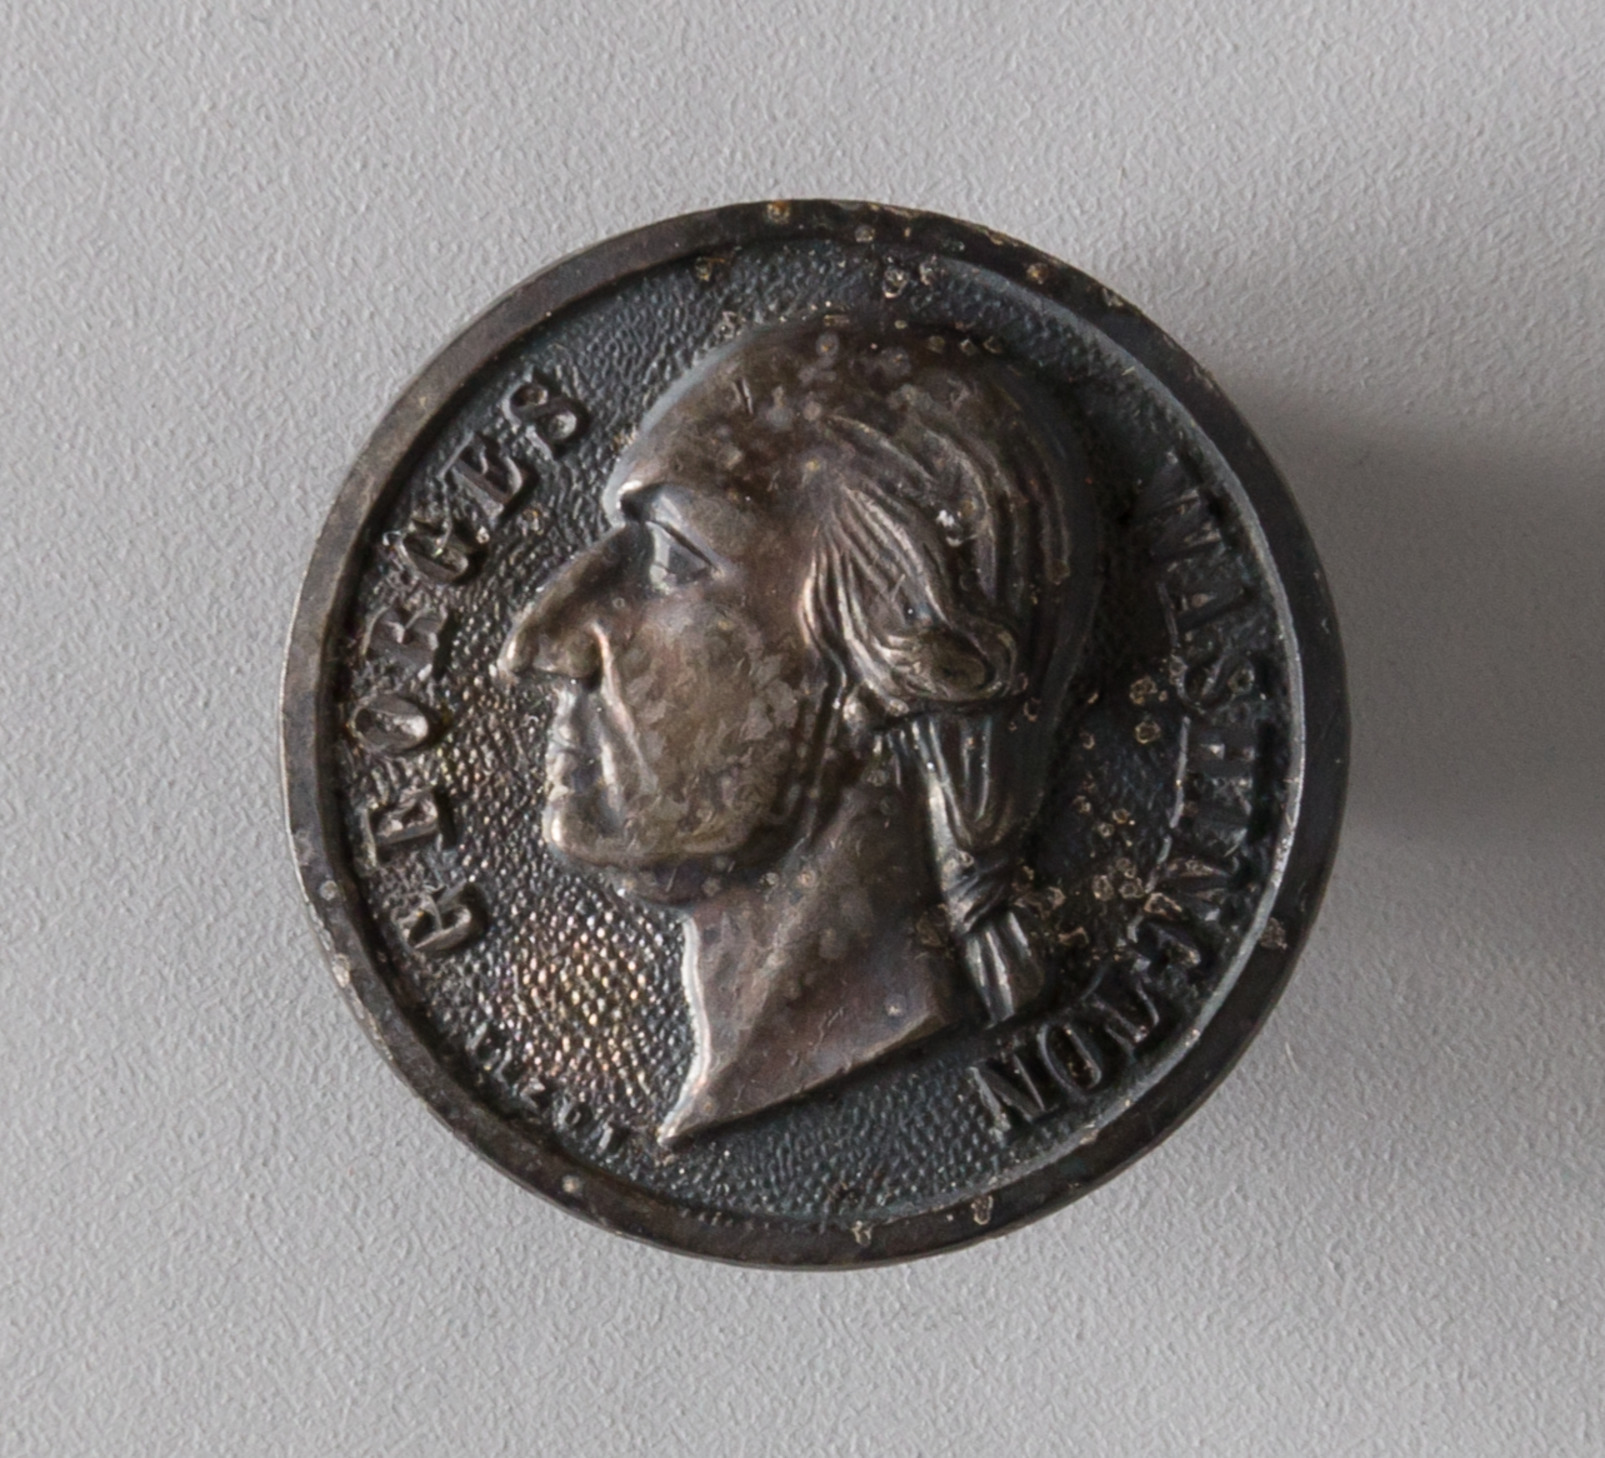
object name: medal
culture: american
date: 1800-1830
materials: silver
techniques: casting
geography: united states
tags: george washington,profiles